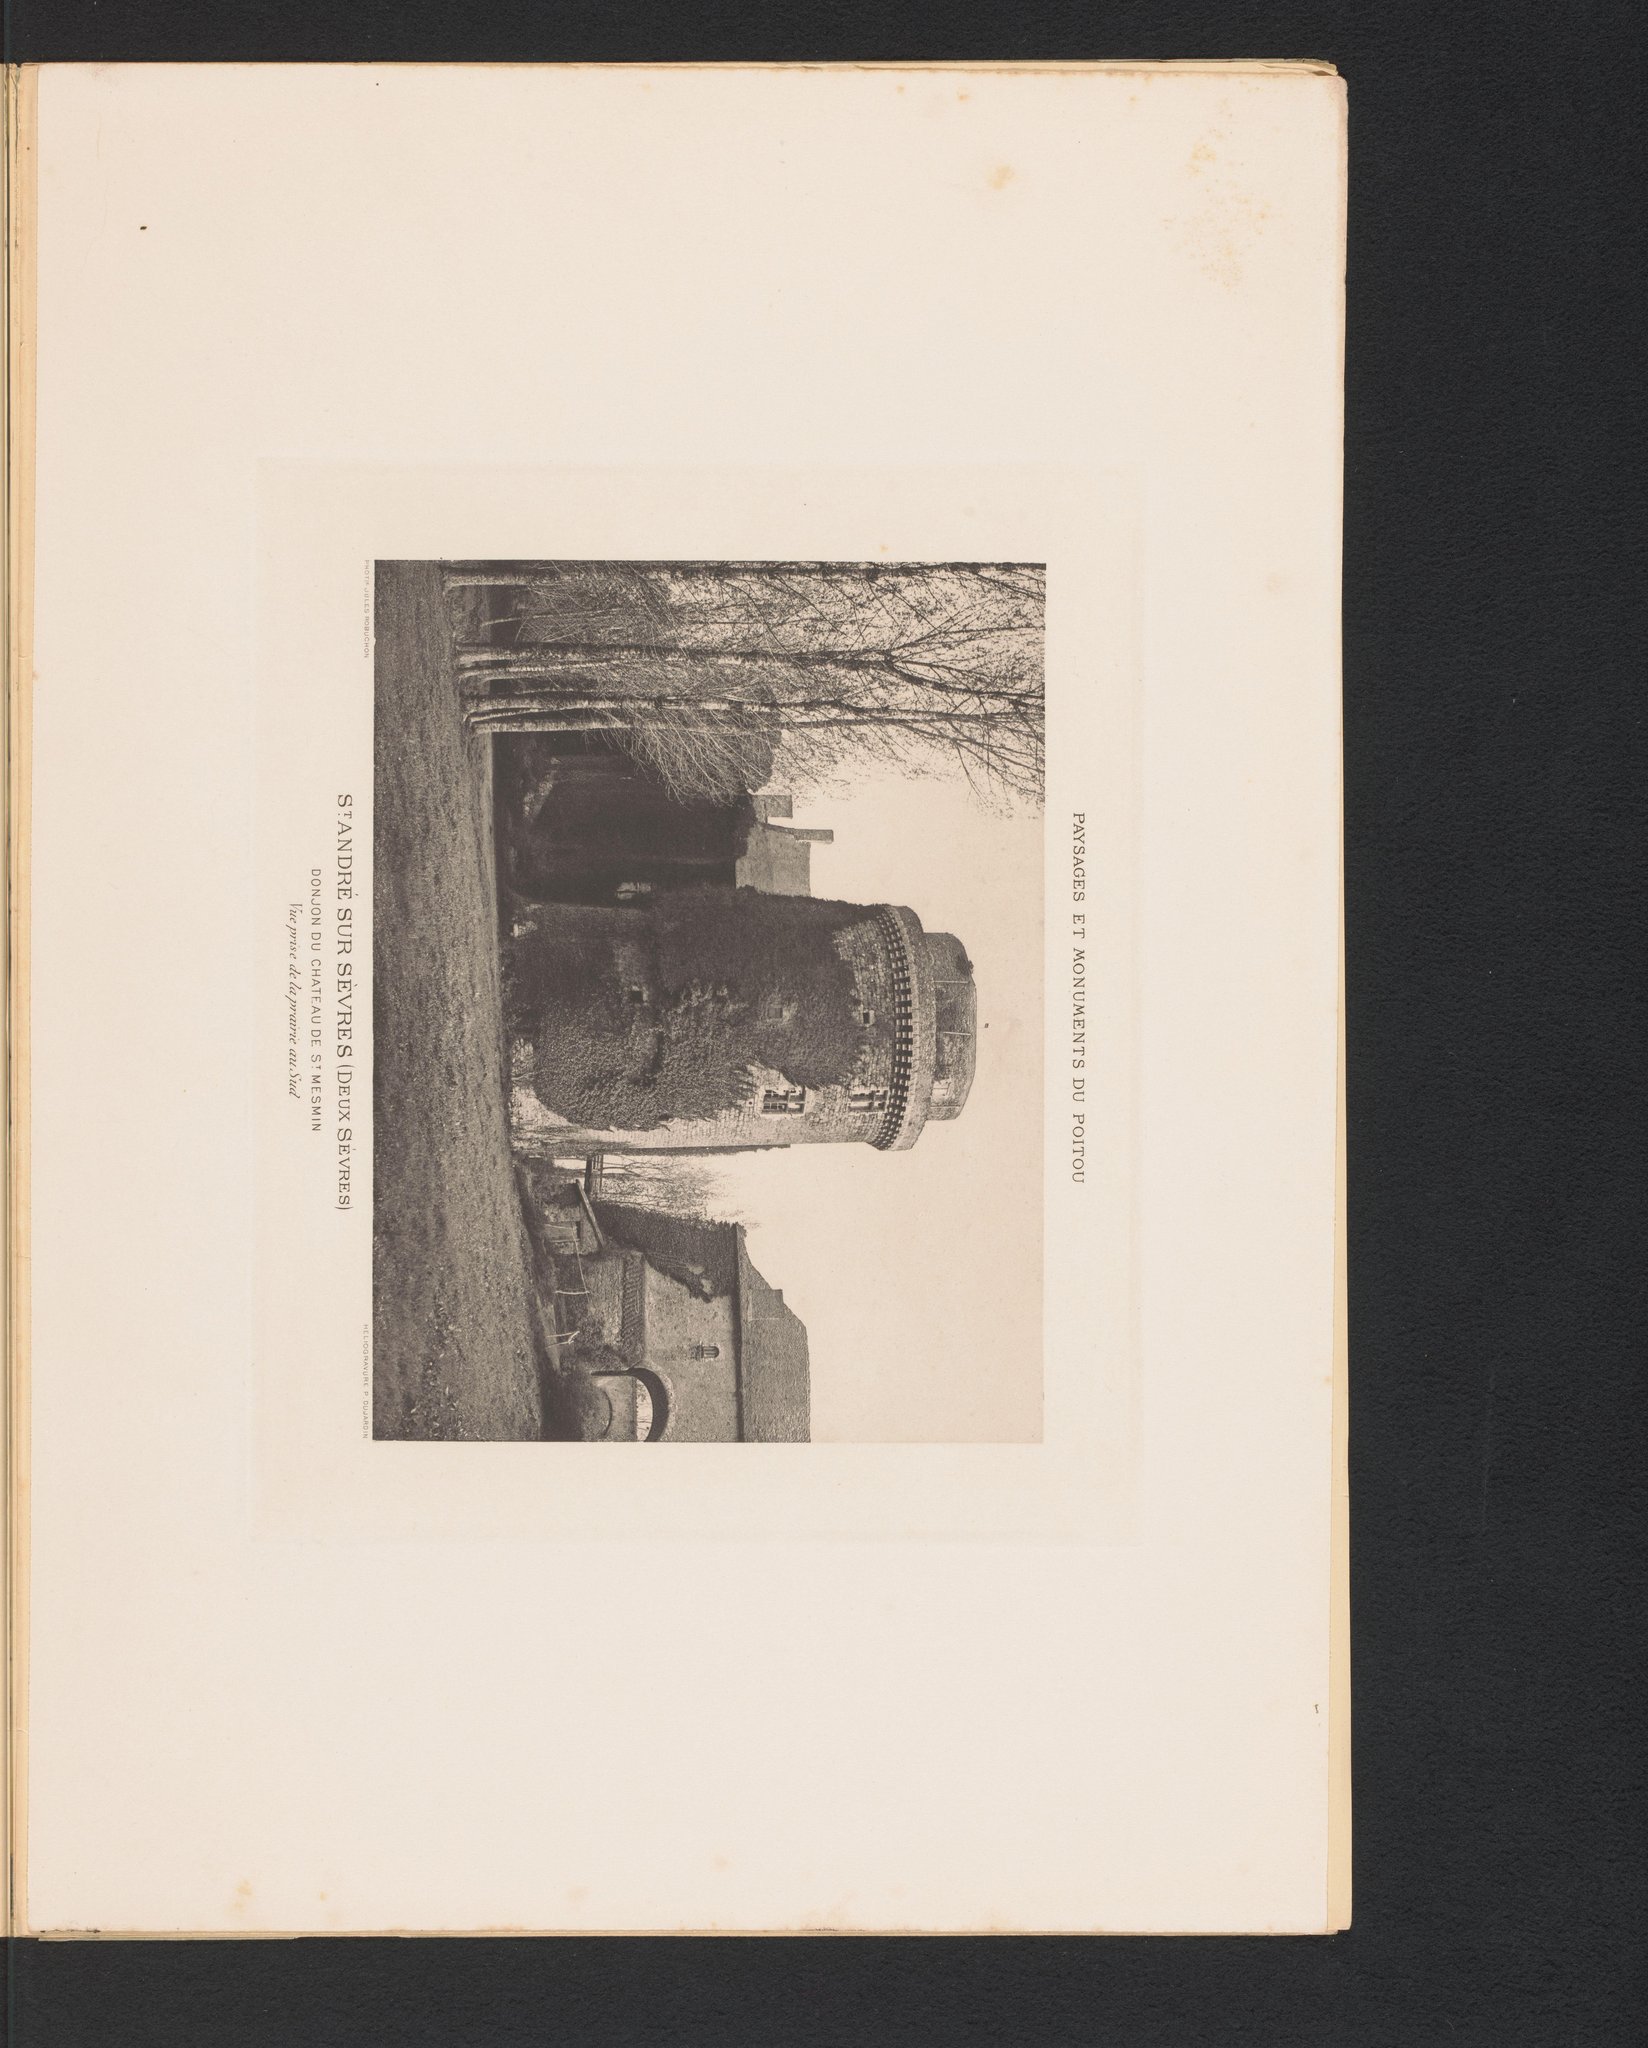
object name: photomechanical print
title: Gezicht op de toren van Château de Mesmin in Saint-André-sur-Sèvre, Frankrijk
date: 1883-1888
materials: paper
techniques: photoaquatint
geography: saint-andré-sur-sèvre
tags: castle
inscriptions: inscription: ‘Vue prise de la prairie au Sud’